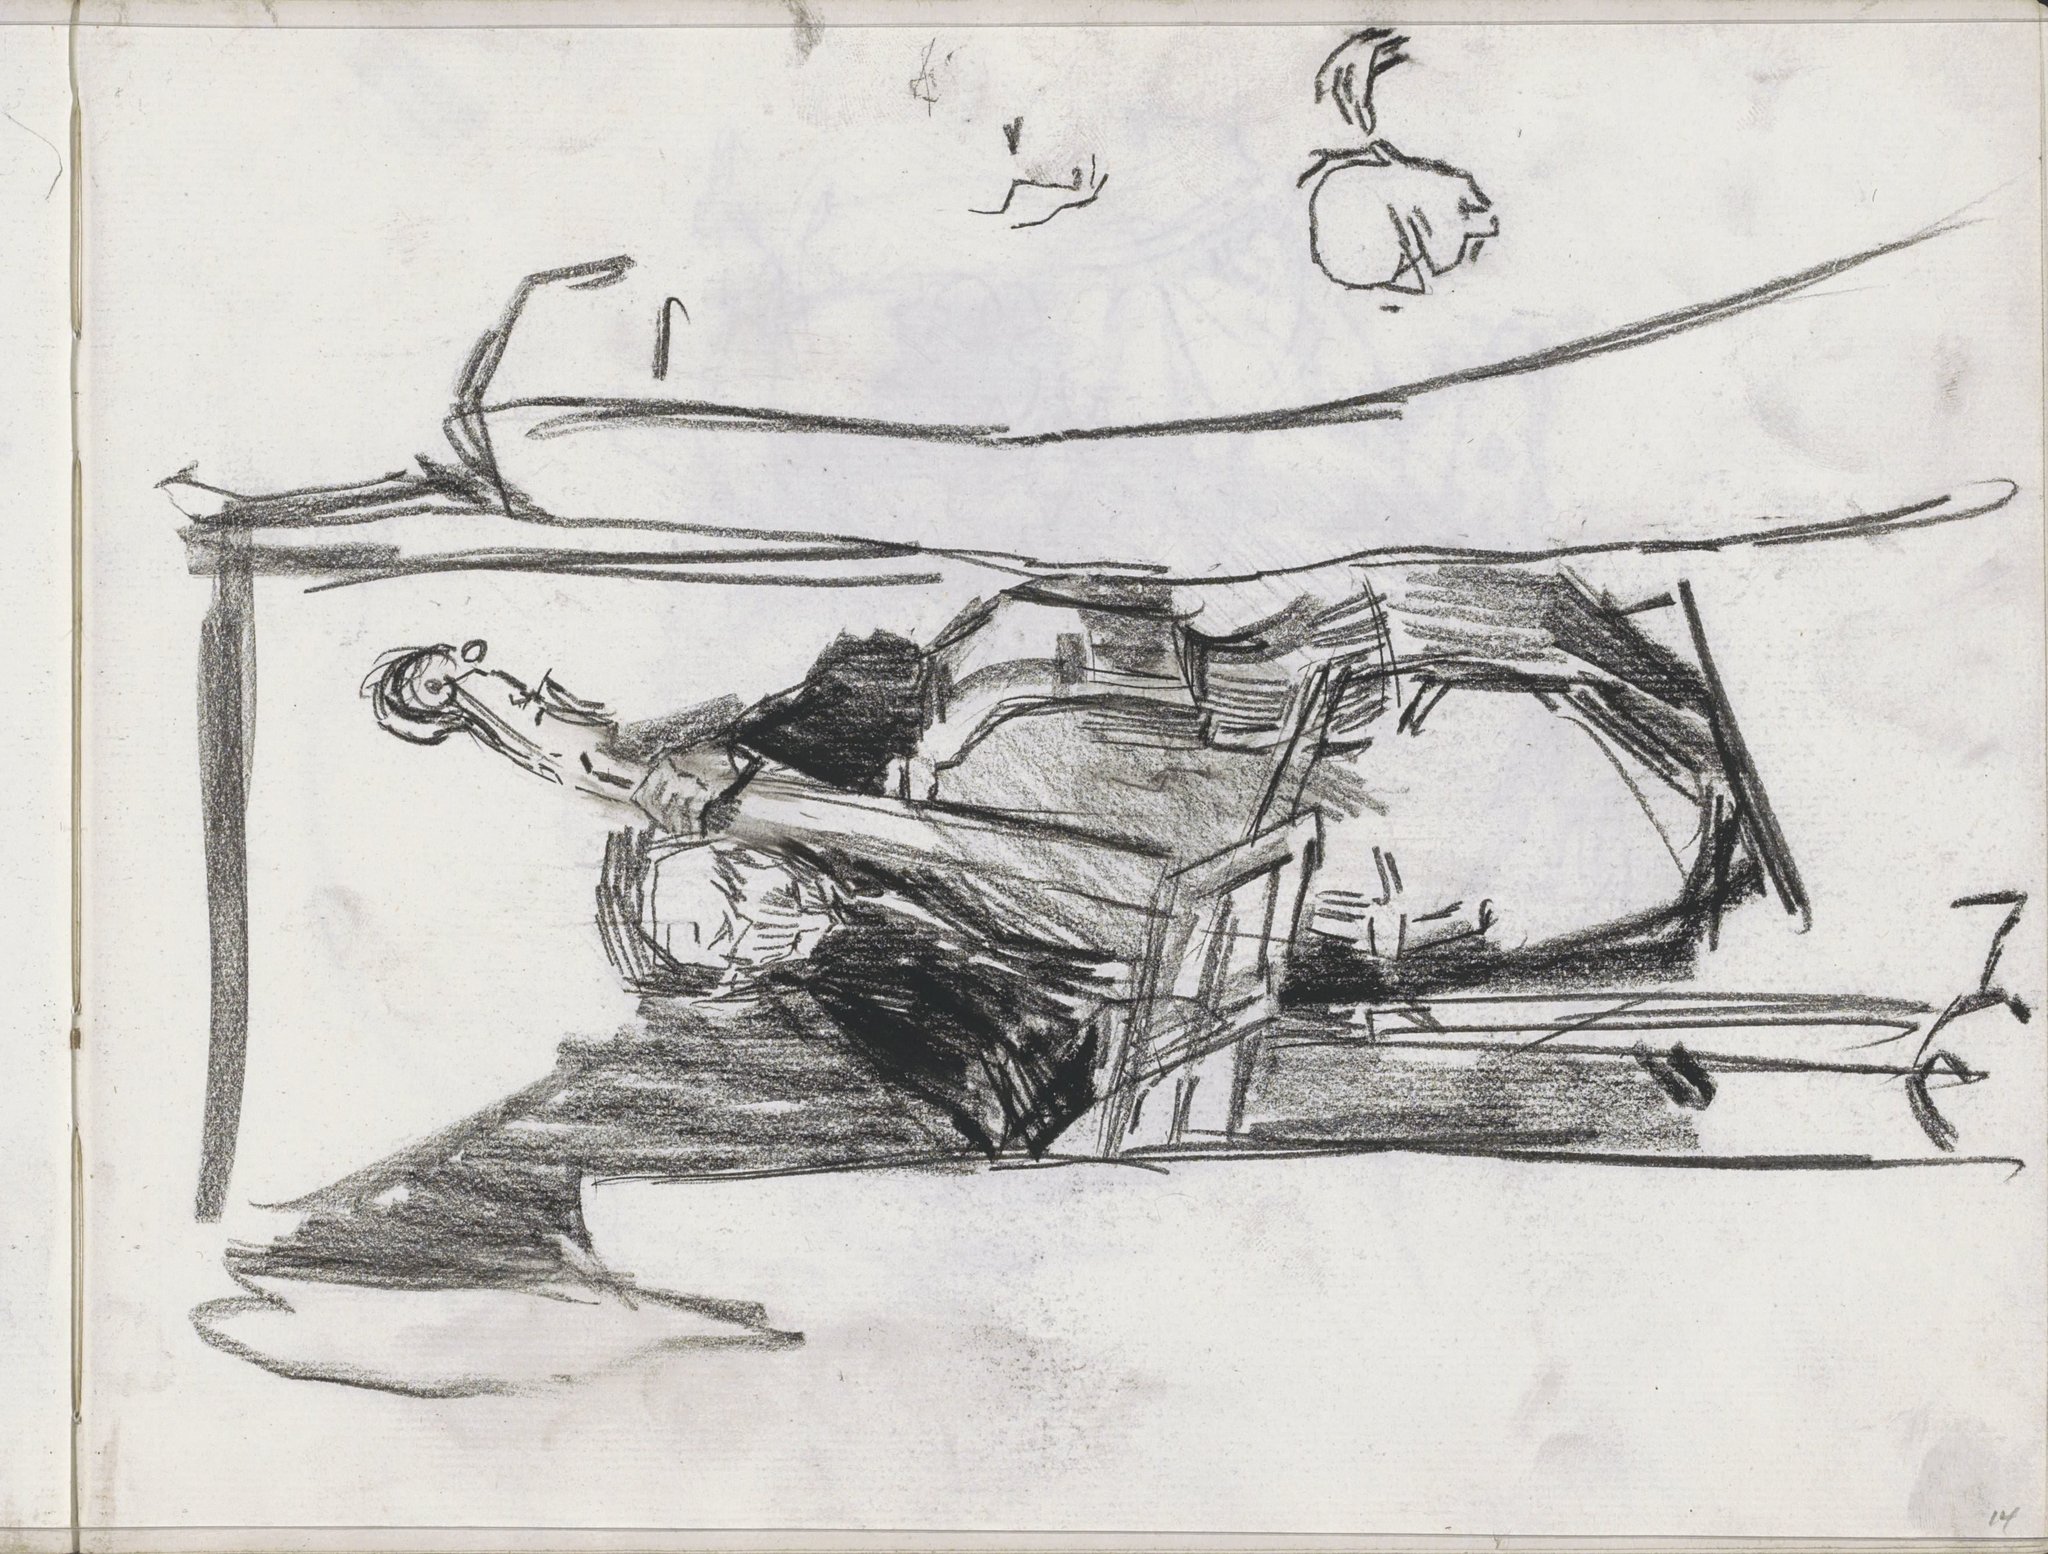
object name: sketchbook leaf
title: Contrabassist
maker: isaac israels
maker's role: draughtsman, painter, print maker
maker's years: 1865-1934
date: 1875-1934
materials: chalk, paper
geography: the hague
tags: viola, violoncello; double bass (+ artist at work)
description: Blad 14 recto uit schetsboek XIV met 17 bladen.